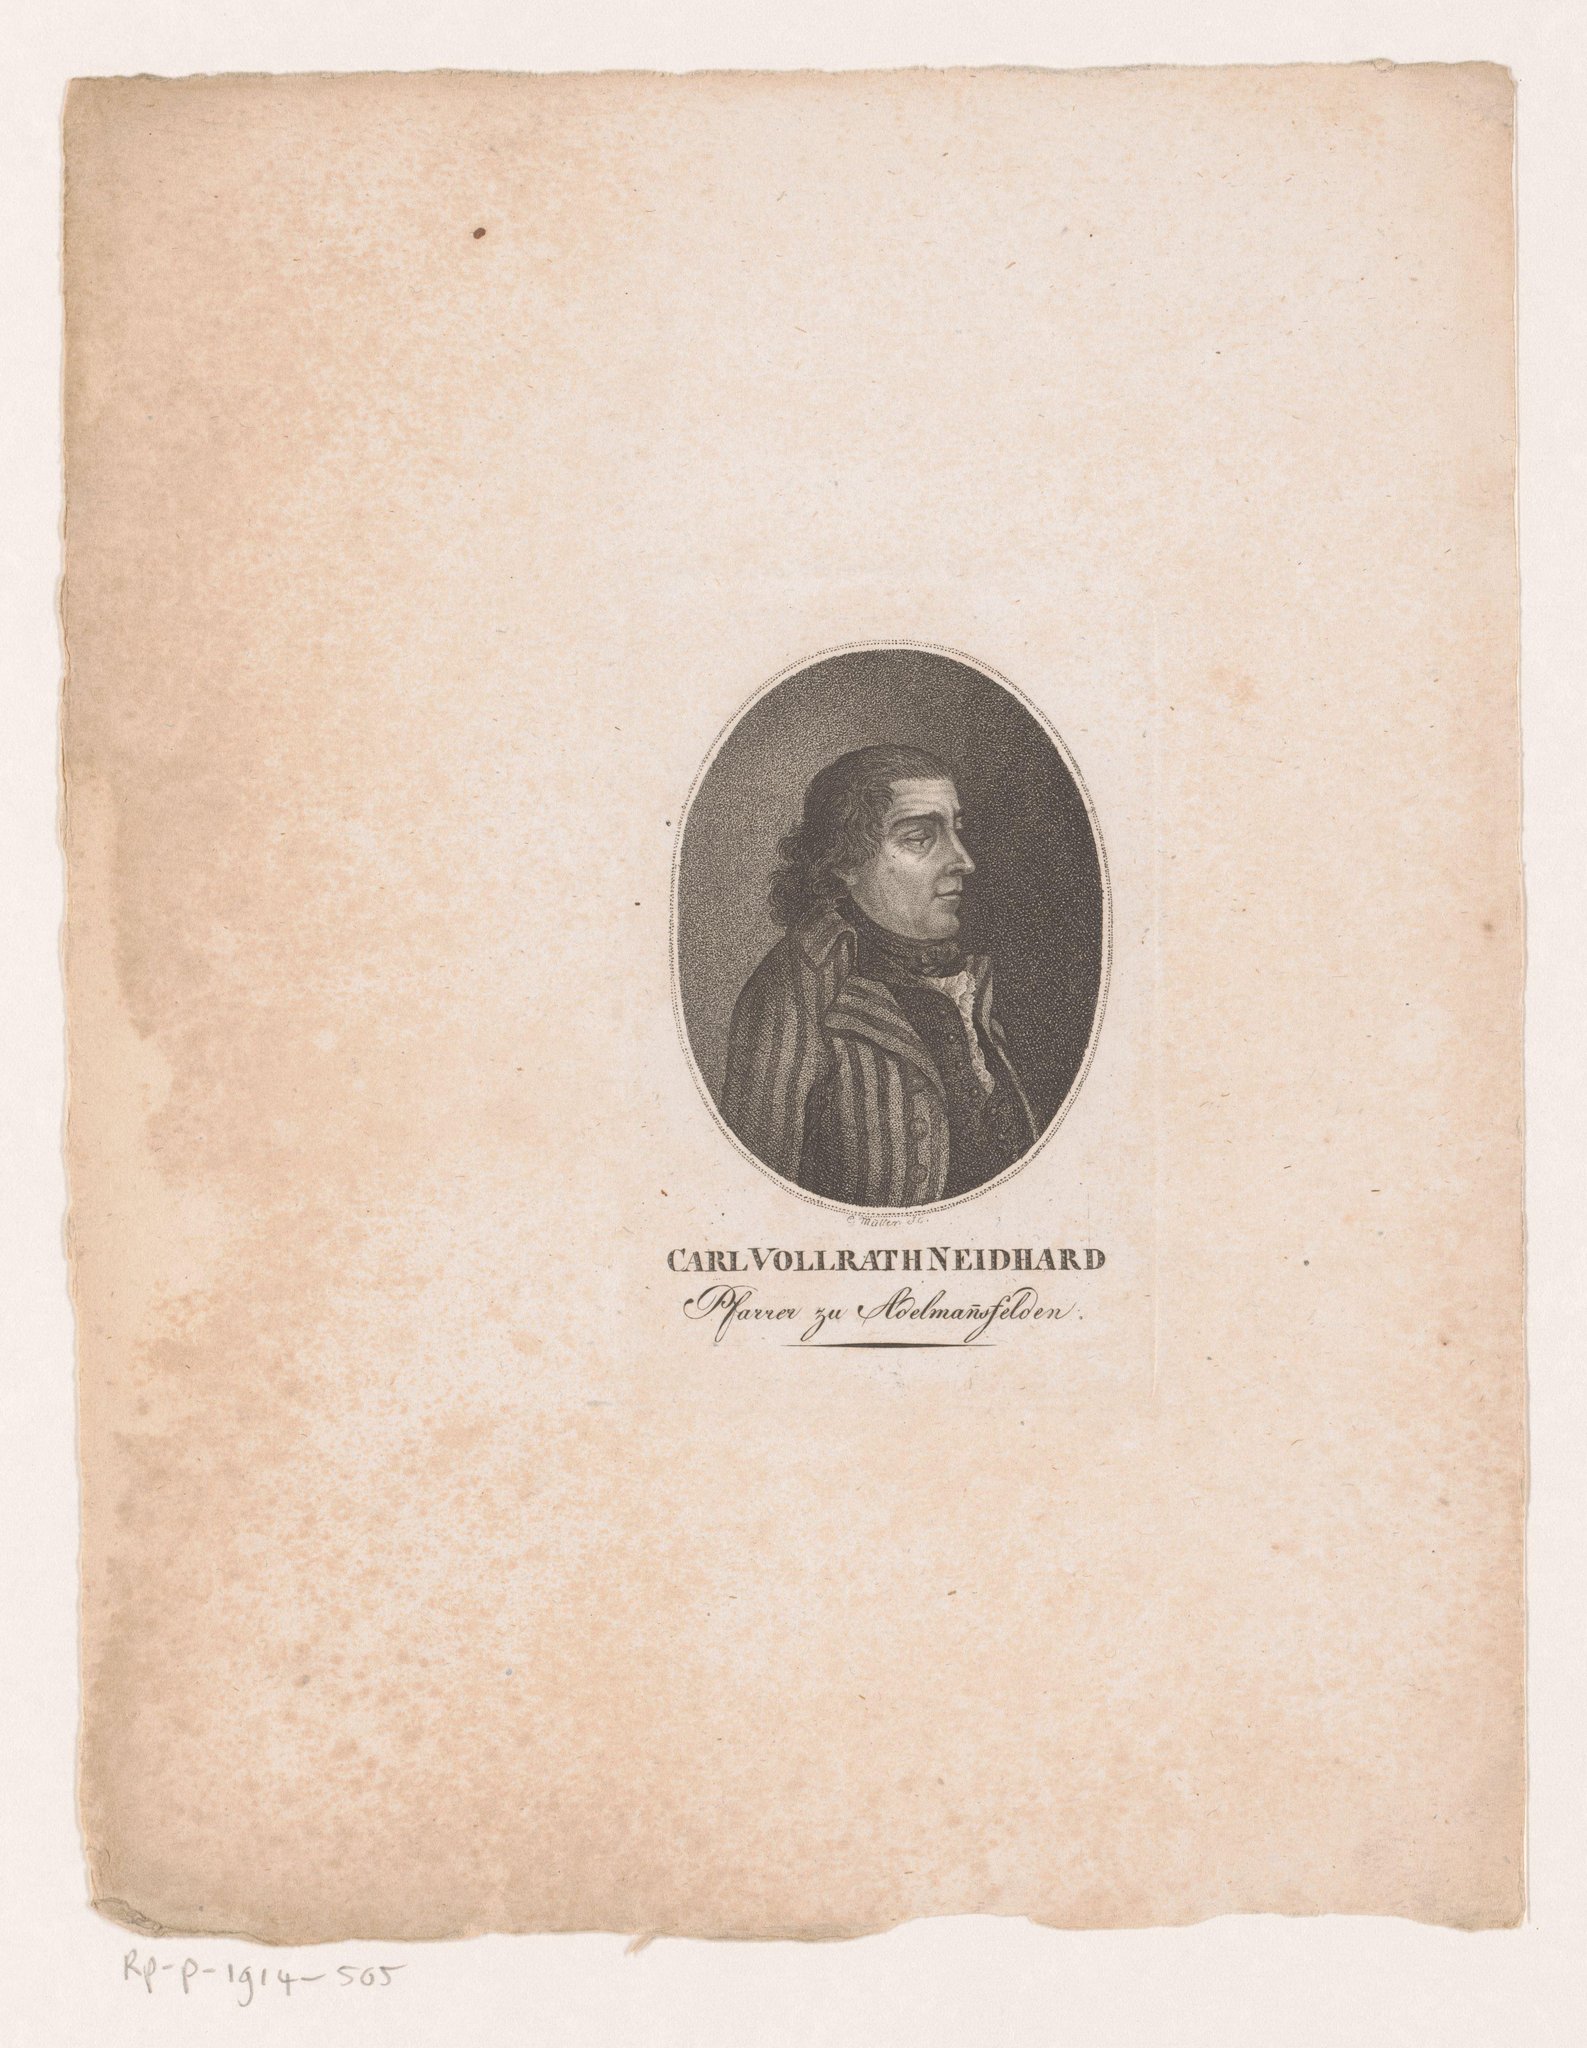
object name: print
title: Portret van Carl Vollrath Neidhard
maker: johann christian ernst müller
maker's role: draughtsman, print maker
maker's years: 1766-1824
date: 1776-1824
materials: paper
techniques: engraving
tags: historical persons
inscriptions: collector's mark: Lugt 2228